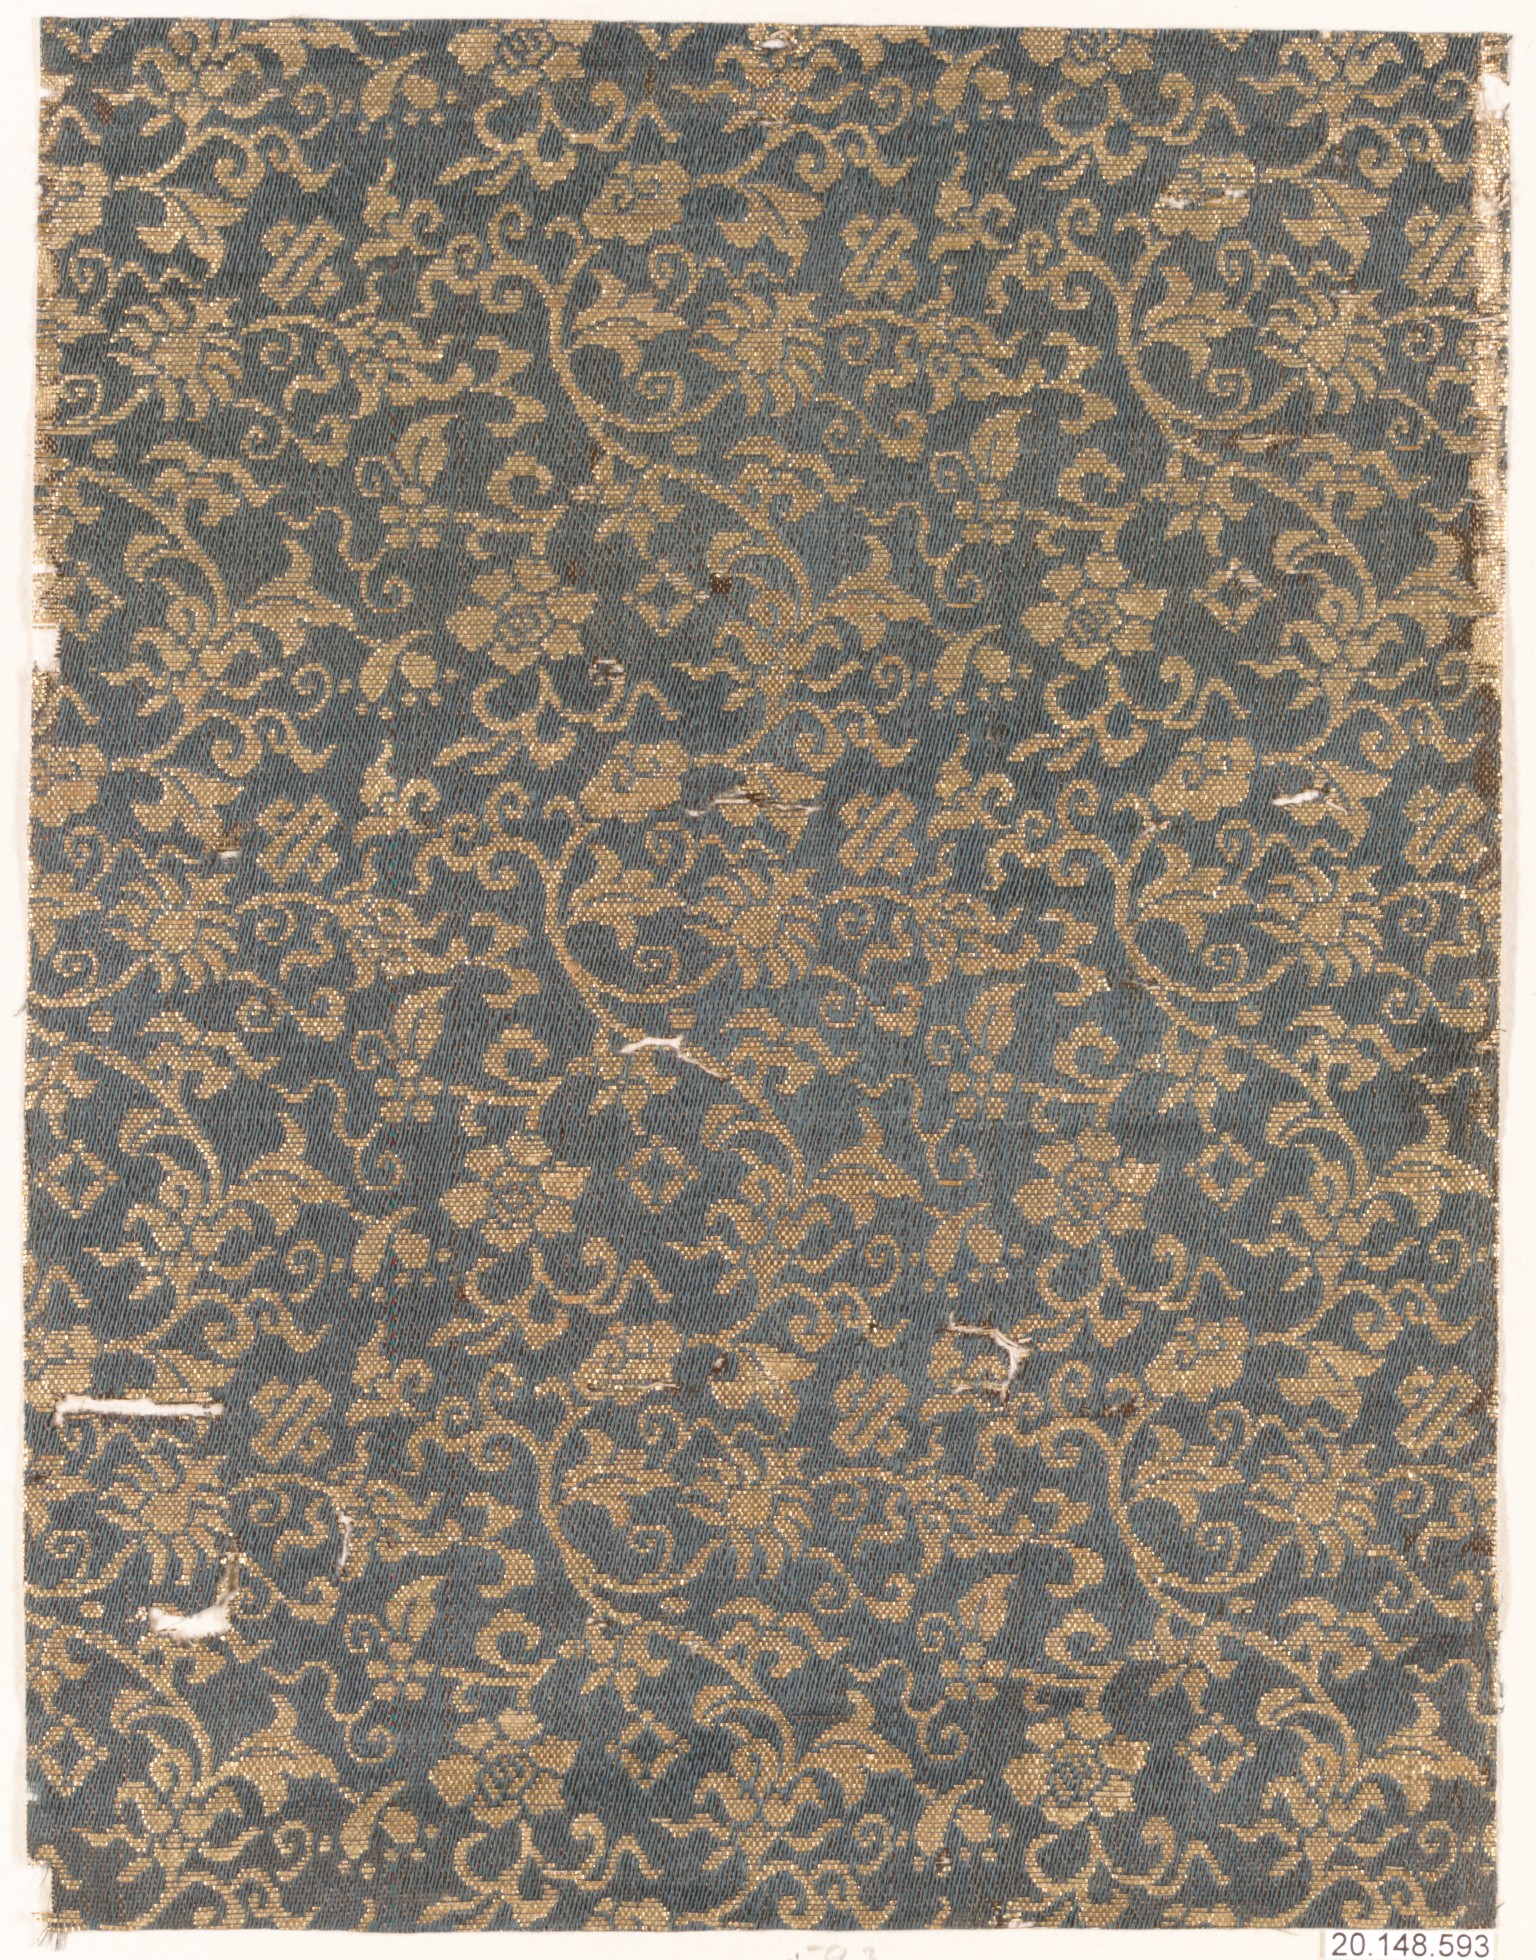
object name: piece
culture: japanese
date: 1601-1700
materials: silk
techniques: compound weave